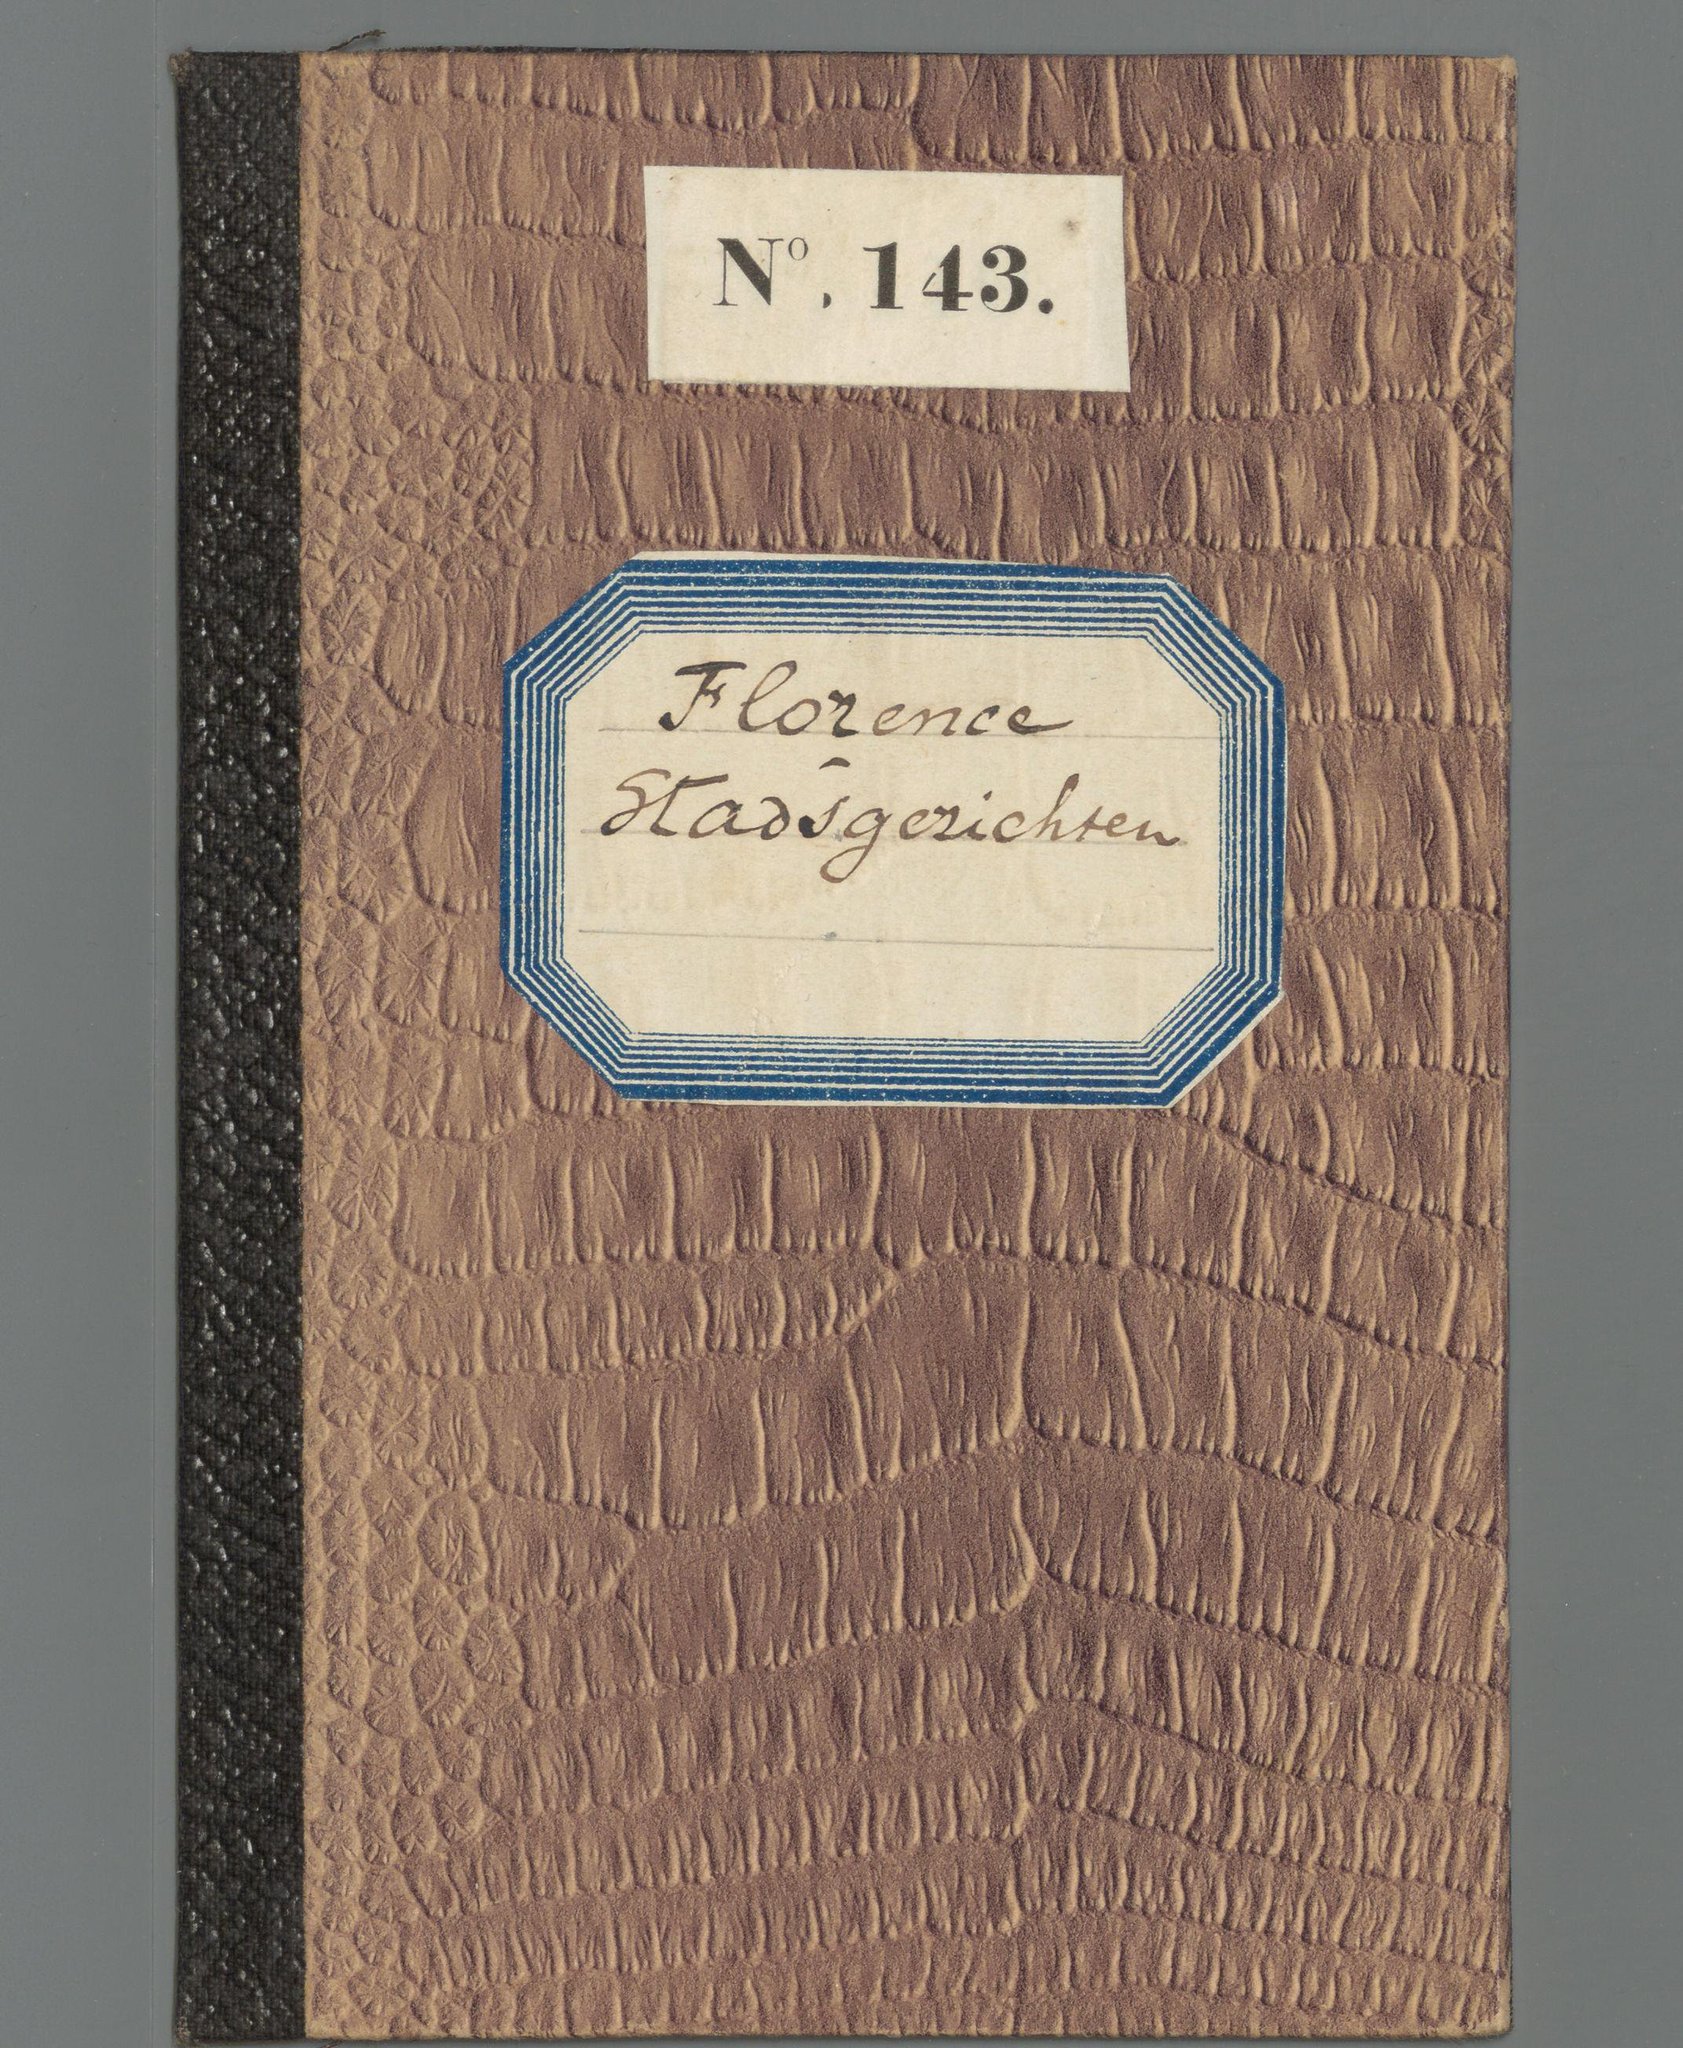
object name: wrapper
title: Florence. Stadsgezichten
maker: Anonymous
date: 1900-1950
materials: cardboard, ink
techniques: pen